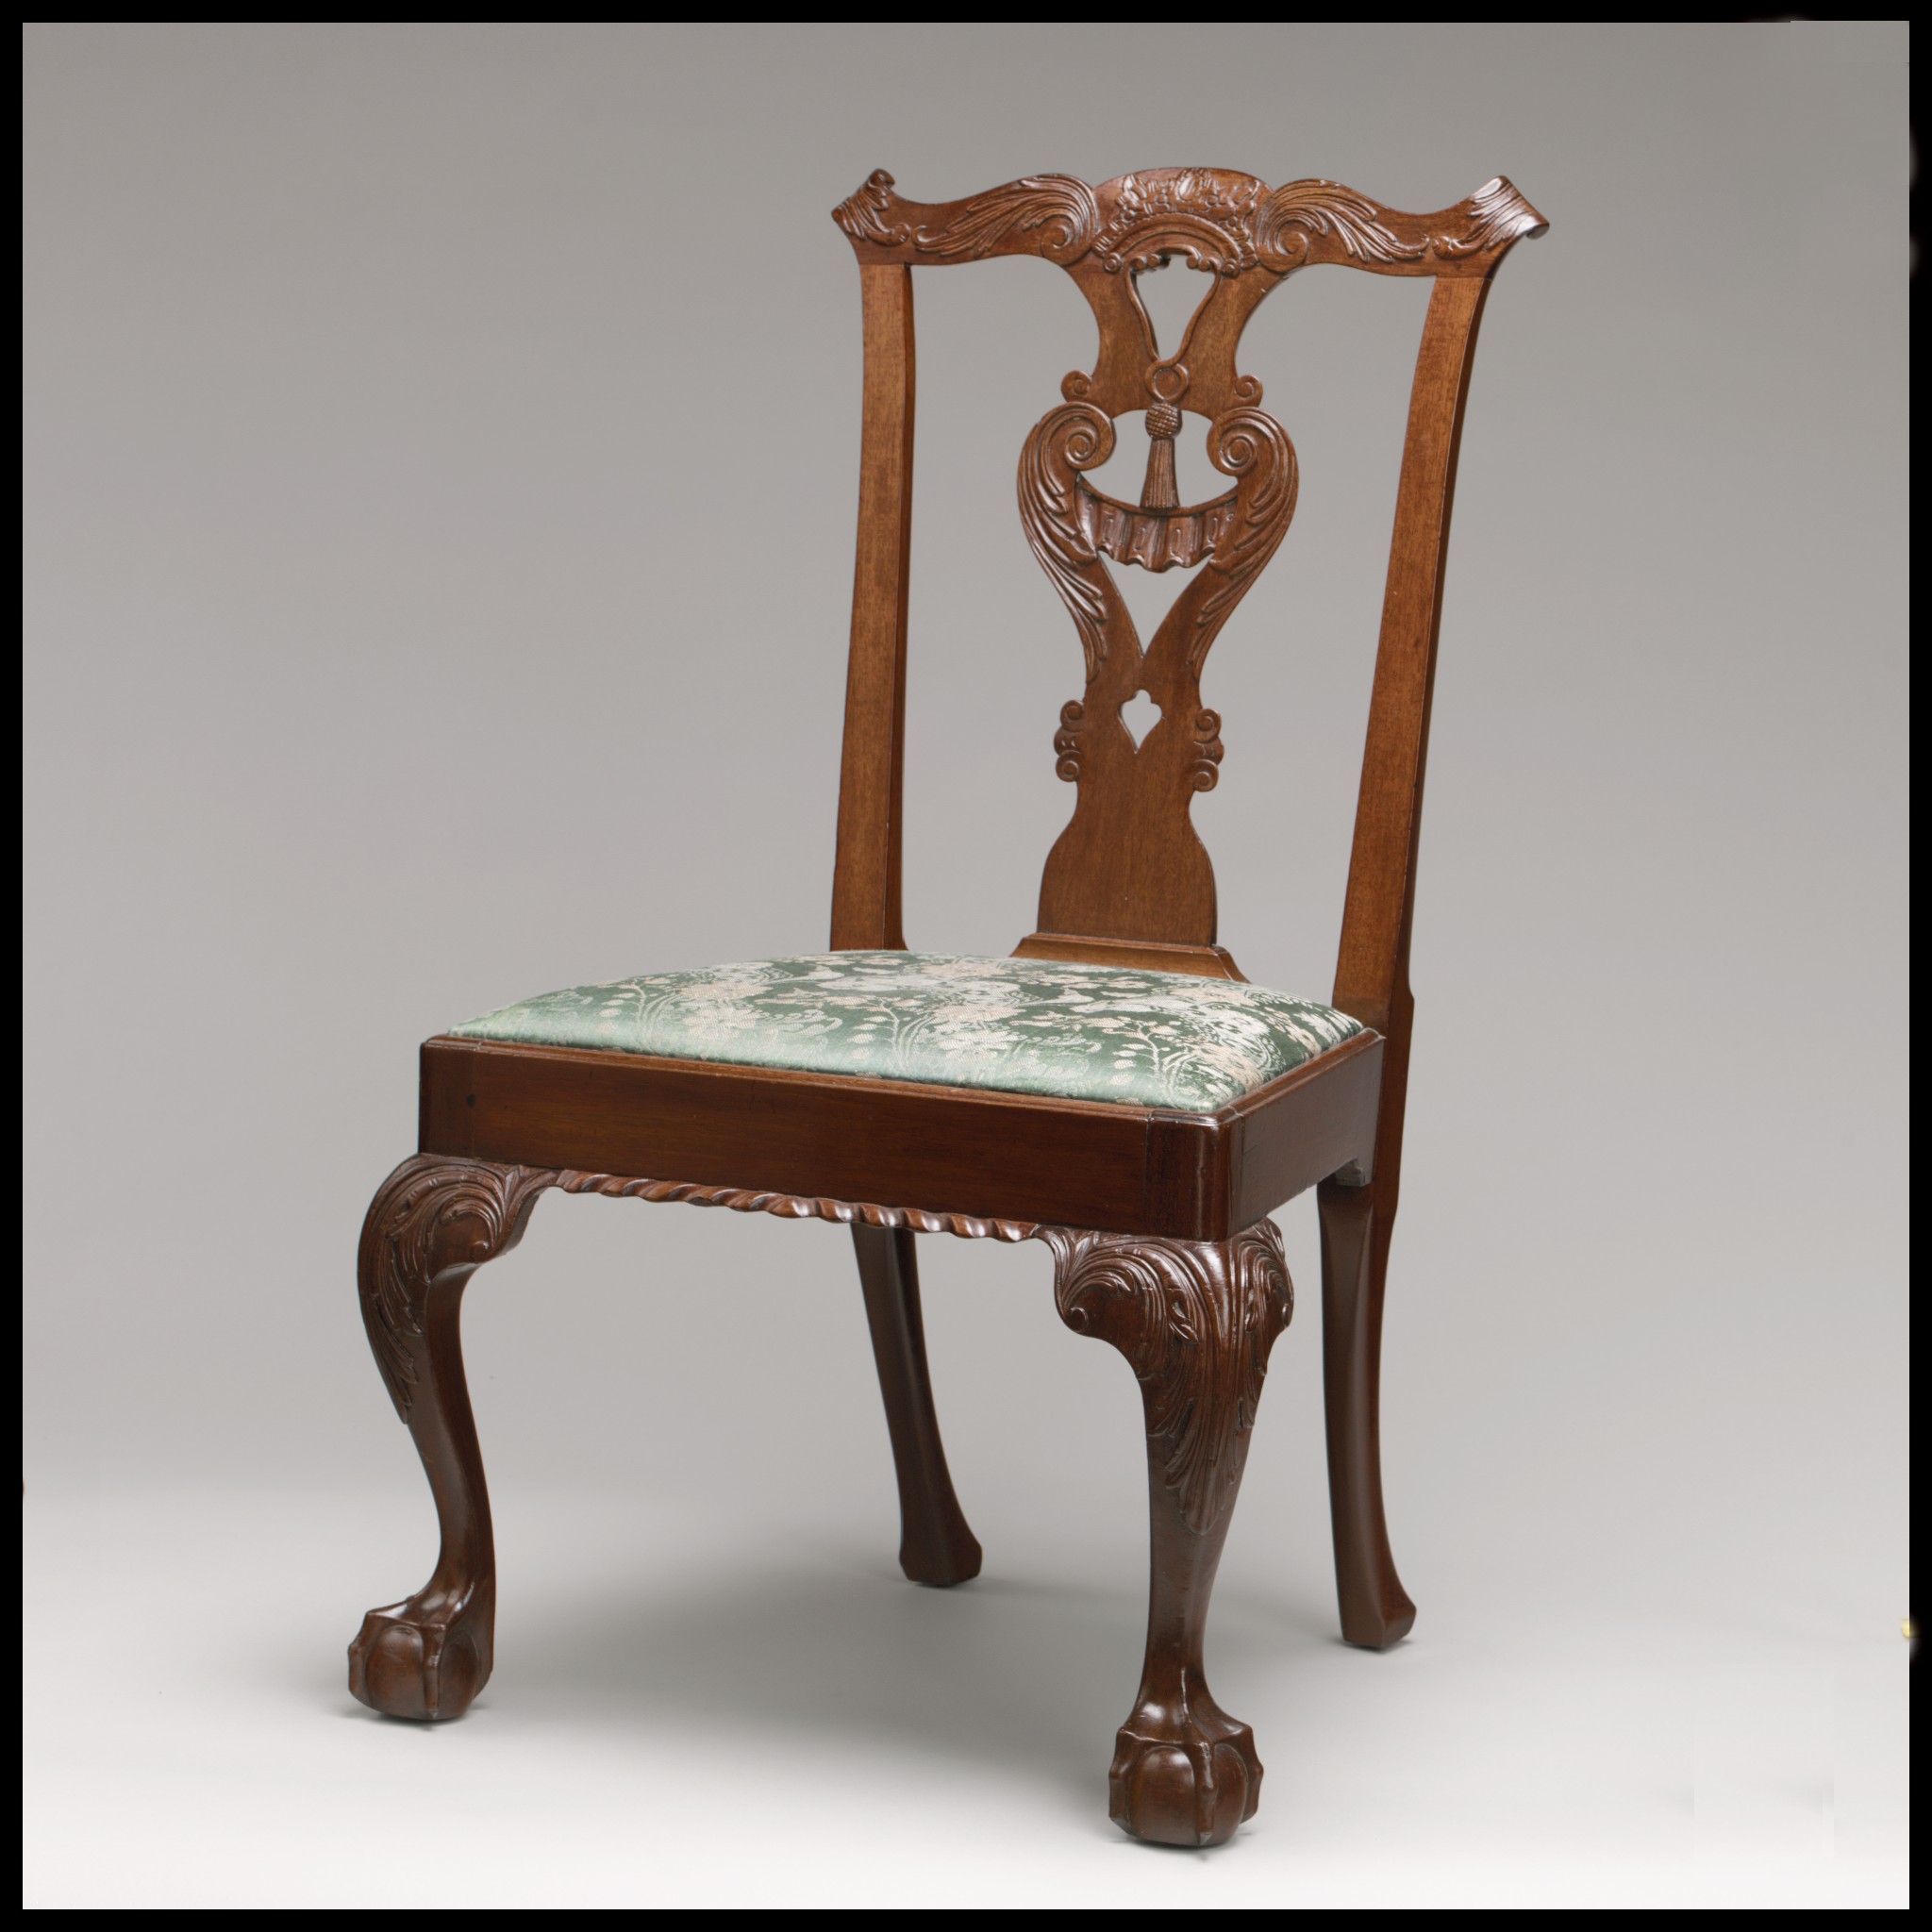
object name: side chair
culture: american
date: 1755-1790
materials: wood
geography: united states